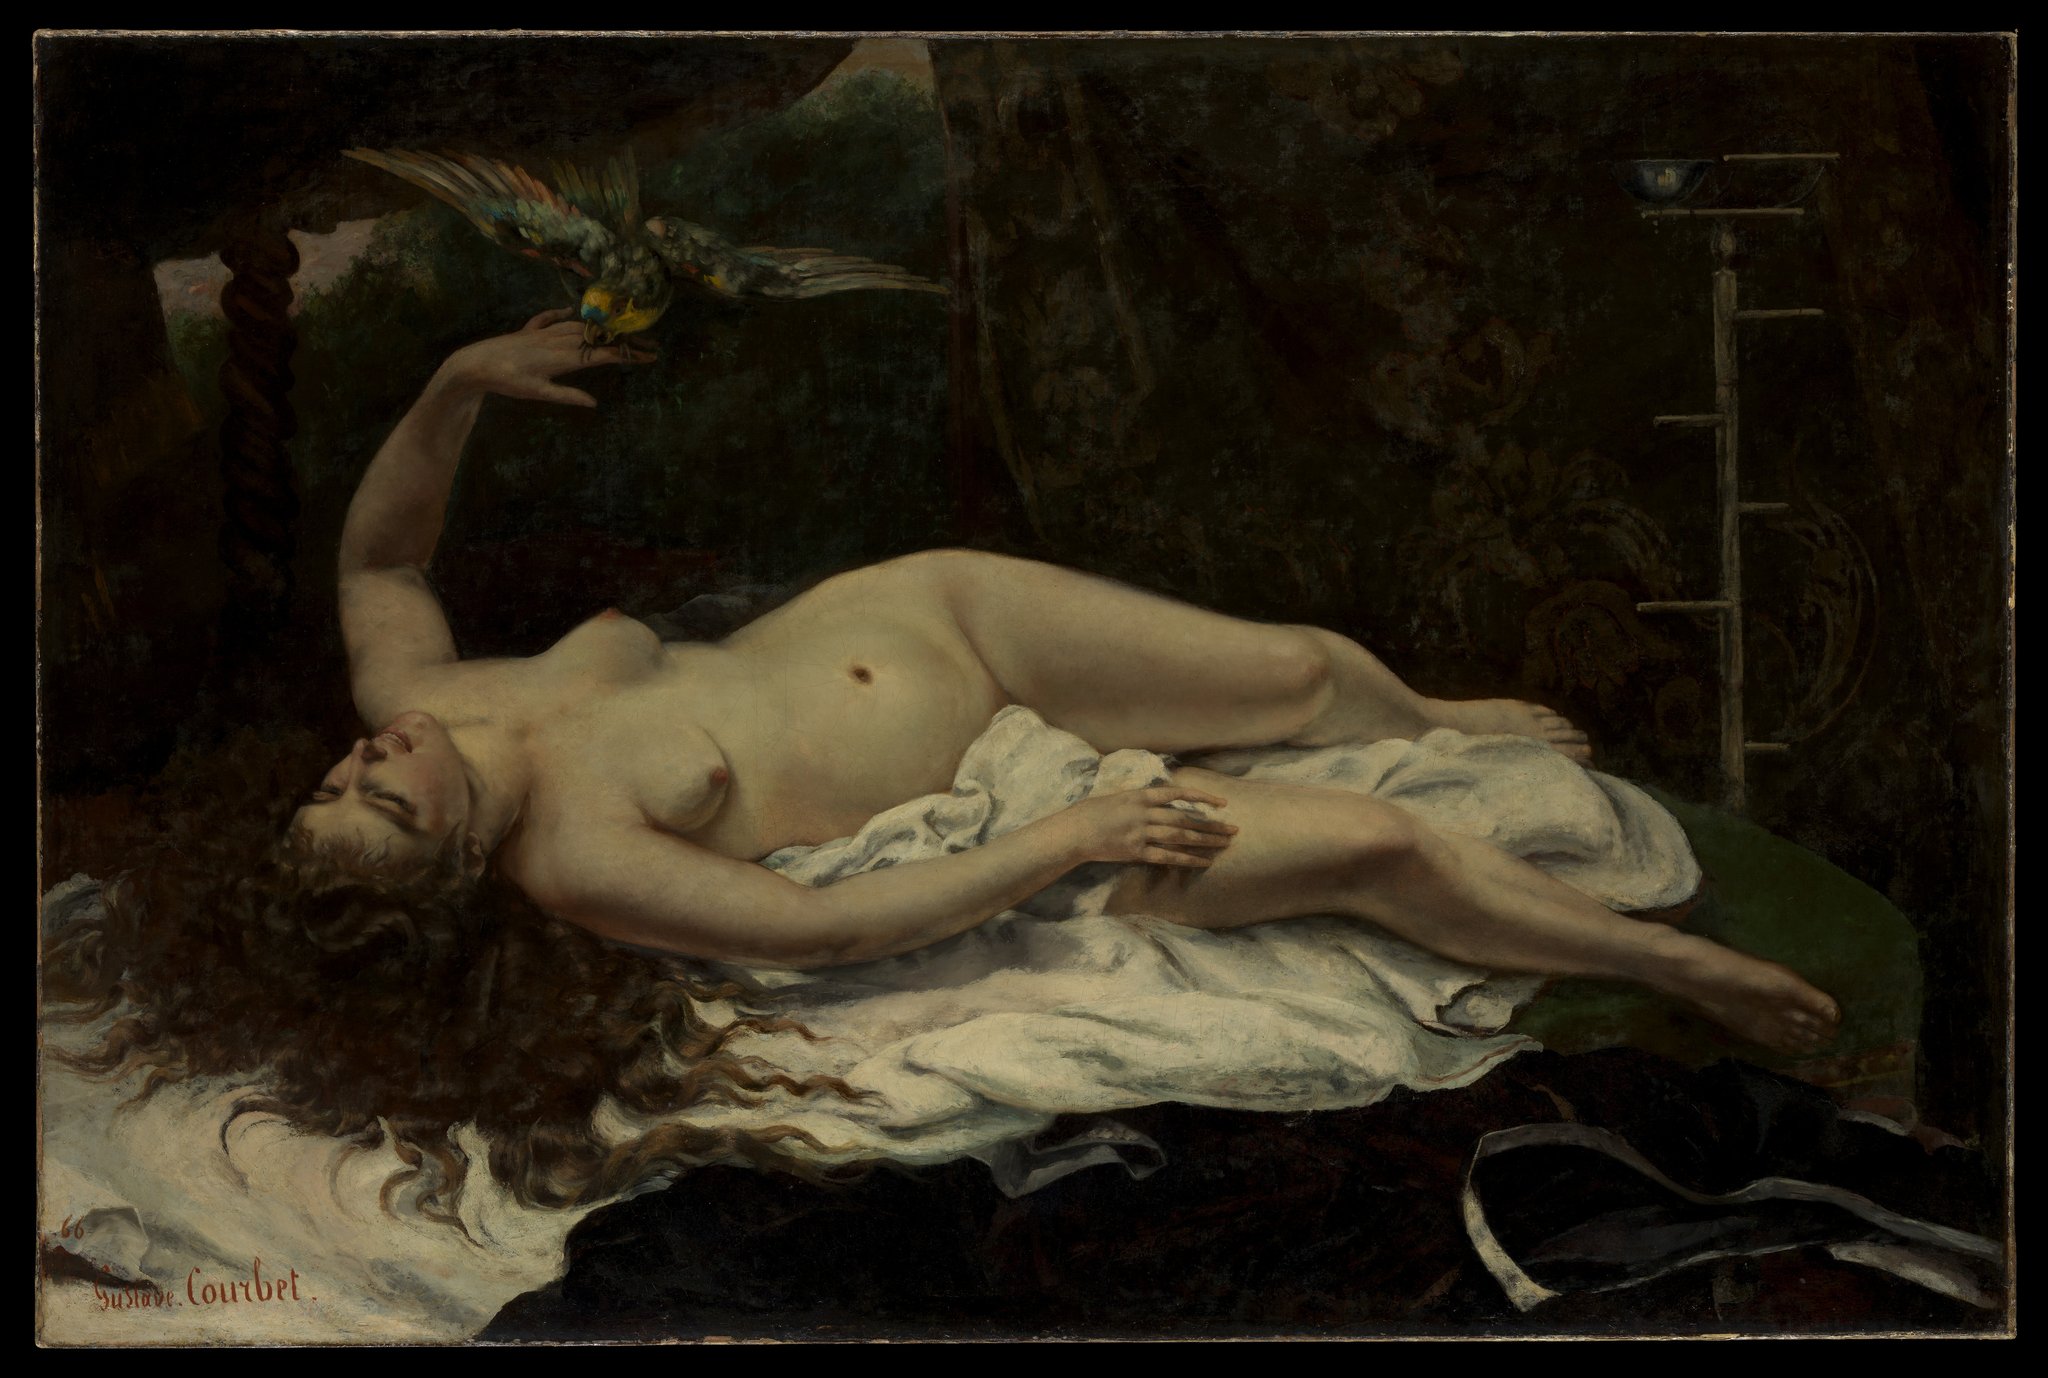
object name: painting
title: Woman with a Parrot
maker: gustave courbet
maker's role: artist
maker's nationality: french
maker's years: 1819-1877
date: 1866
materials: canvas, oil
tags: female nudes,parrots